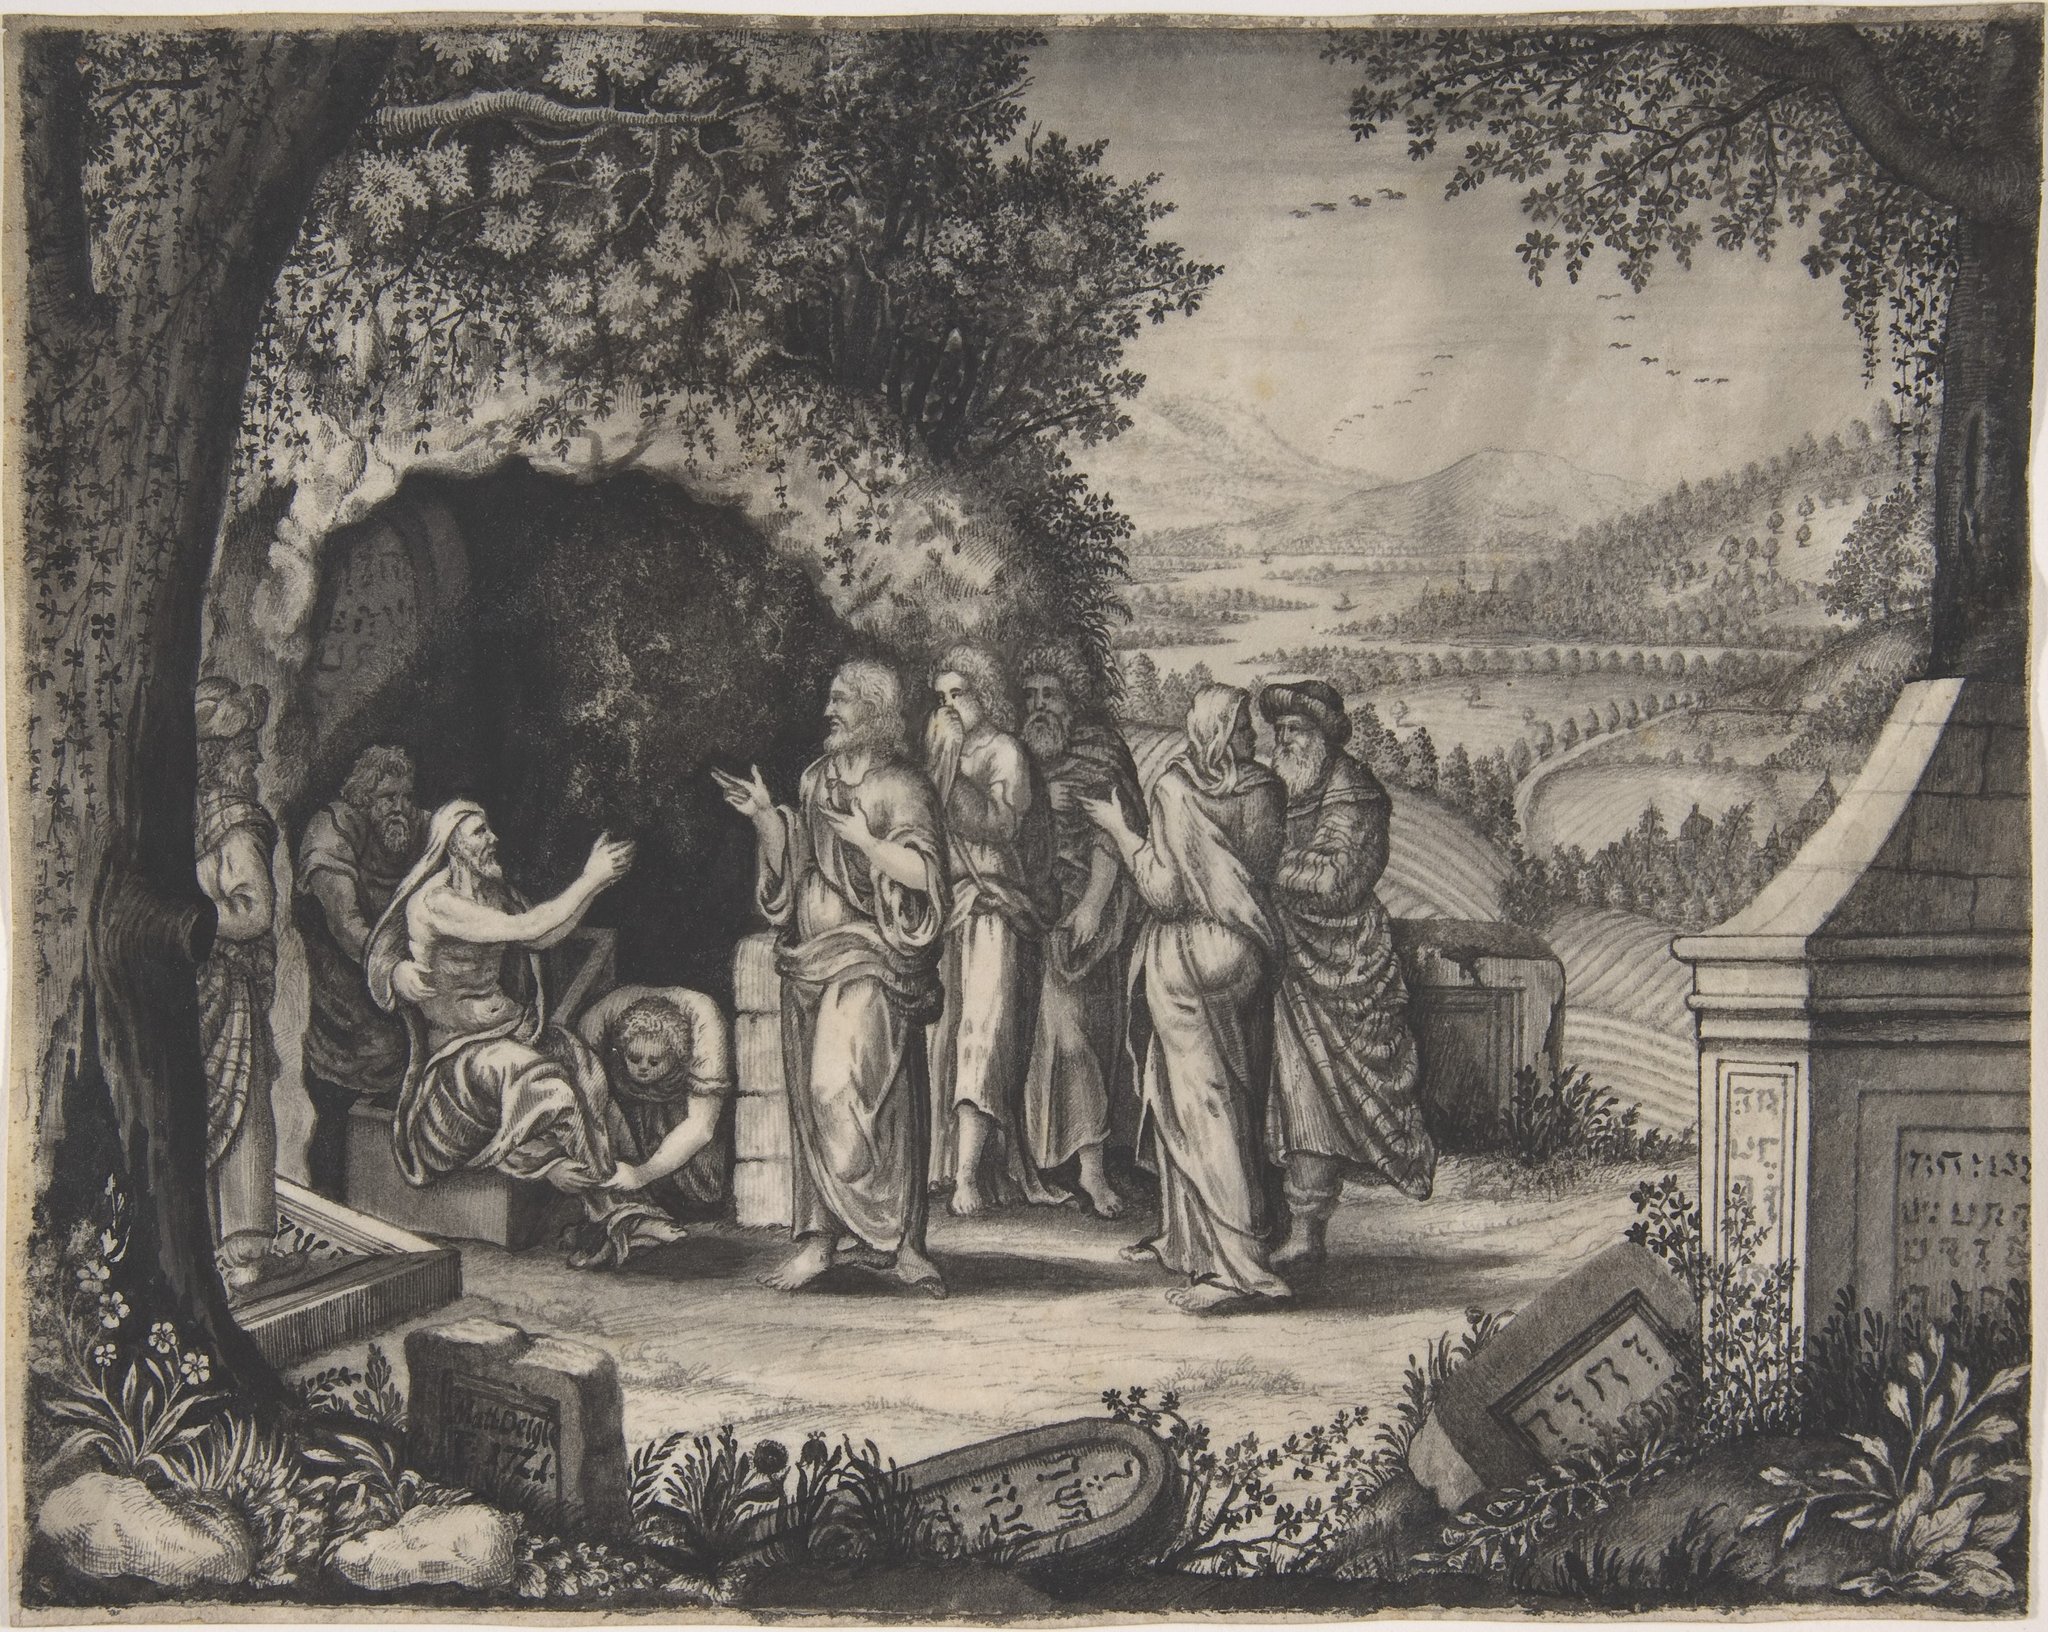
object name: drawing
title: The Raising of Lazarus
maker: matthias deigle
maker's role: artist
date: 1701-1800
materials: ink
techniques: brush, pen, wash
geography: germany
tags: men,trees,jesus